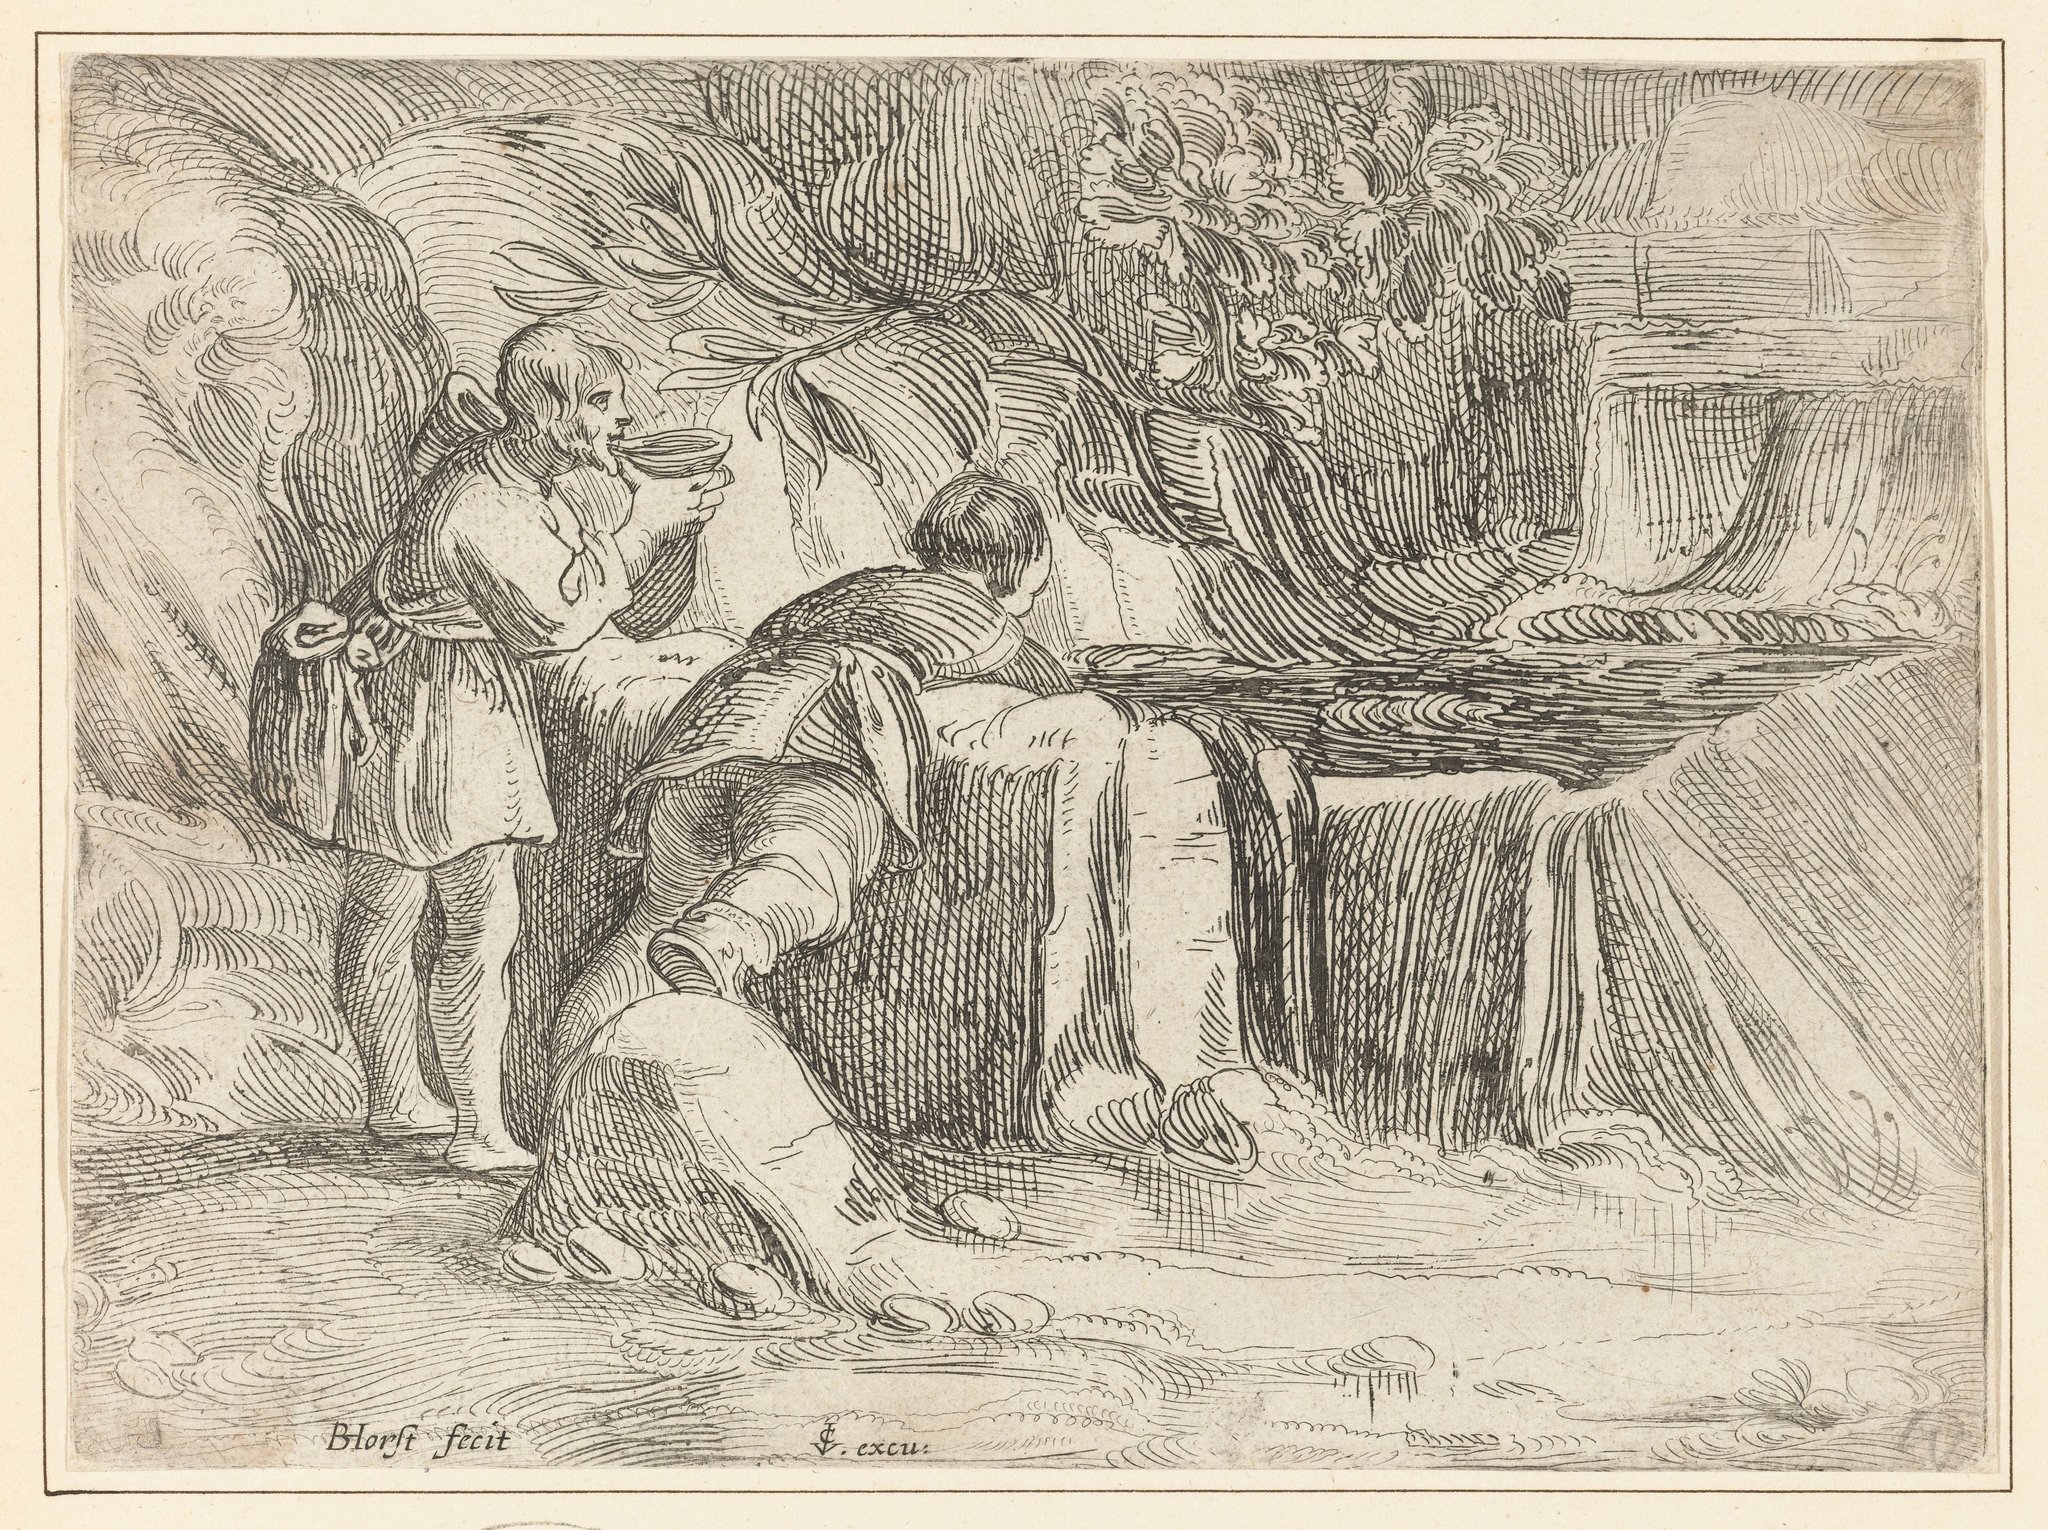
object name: print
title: Twee mannen bij een bron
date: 1603-1631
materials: paper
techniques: etching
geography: amsterdam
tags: well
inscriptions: address: ‘CV. excu’ CV = Claes jansz.. Visscher, collector's mark: Lugt 2228, collector's mark: 2760, signature: ‘BHorst fecit’ Lugt BHorst = Jan Philipsz. van Bouckhorst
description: Twee mannen bij een bron in de rotsen. De een drinkt uit een nap, de ander, op de rug gezien, buigt zich voorover om water te scheppen uit de bron.